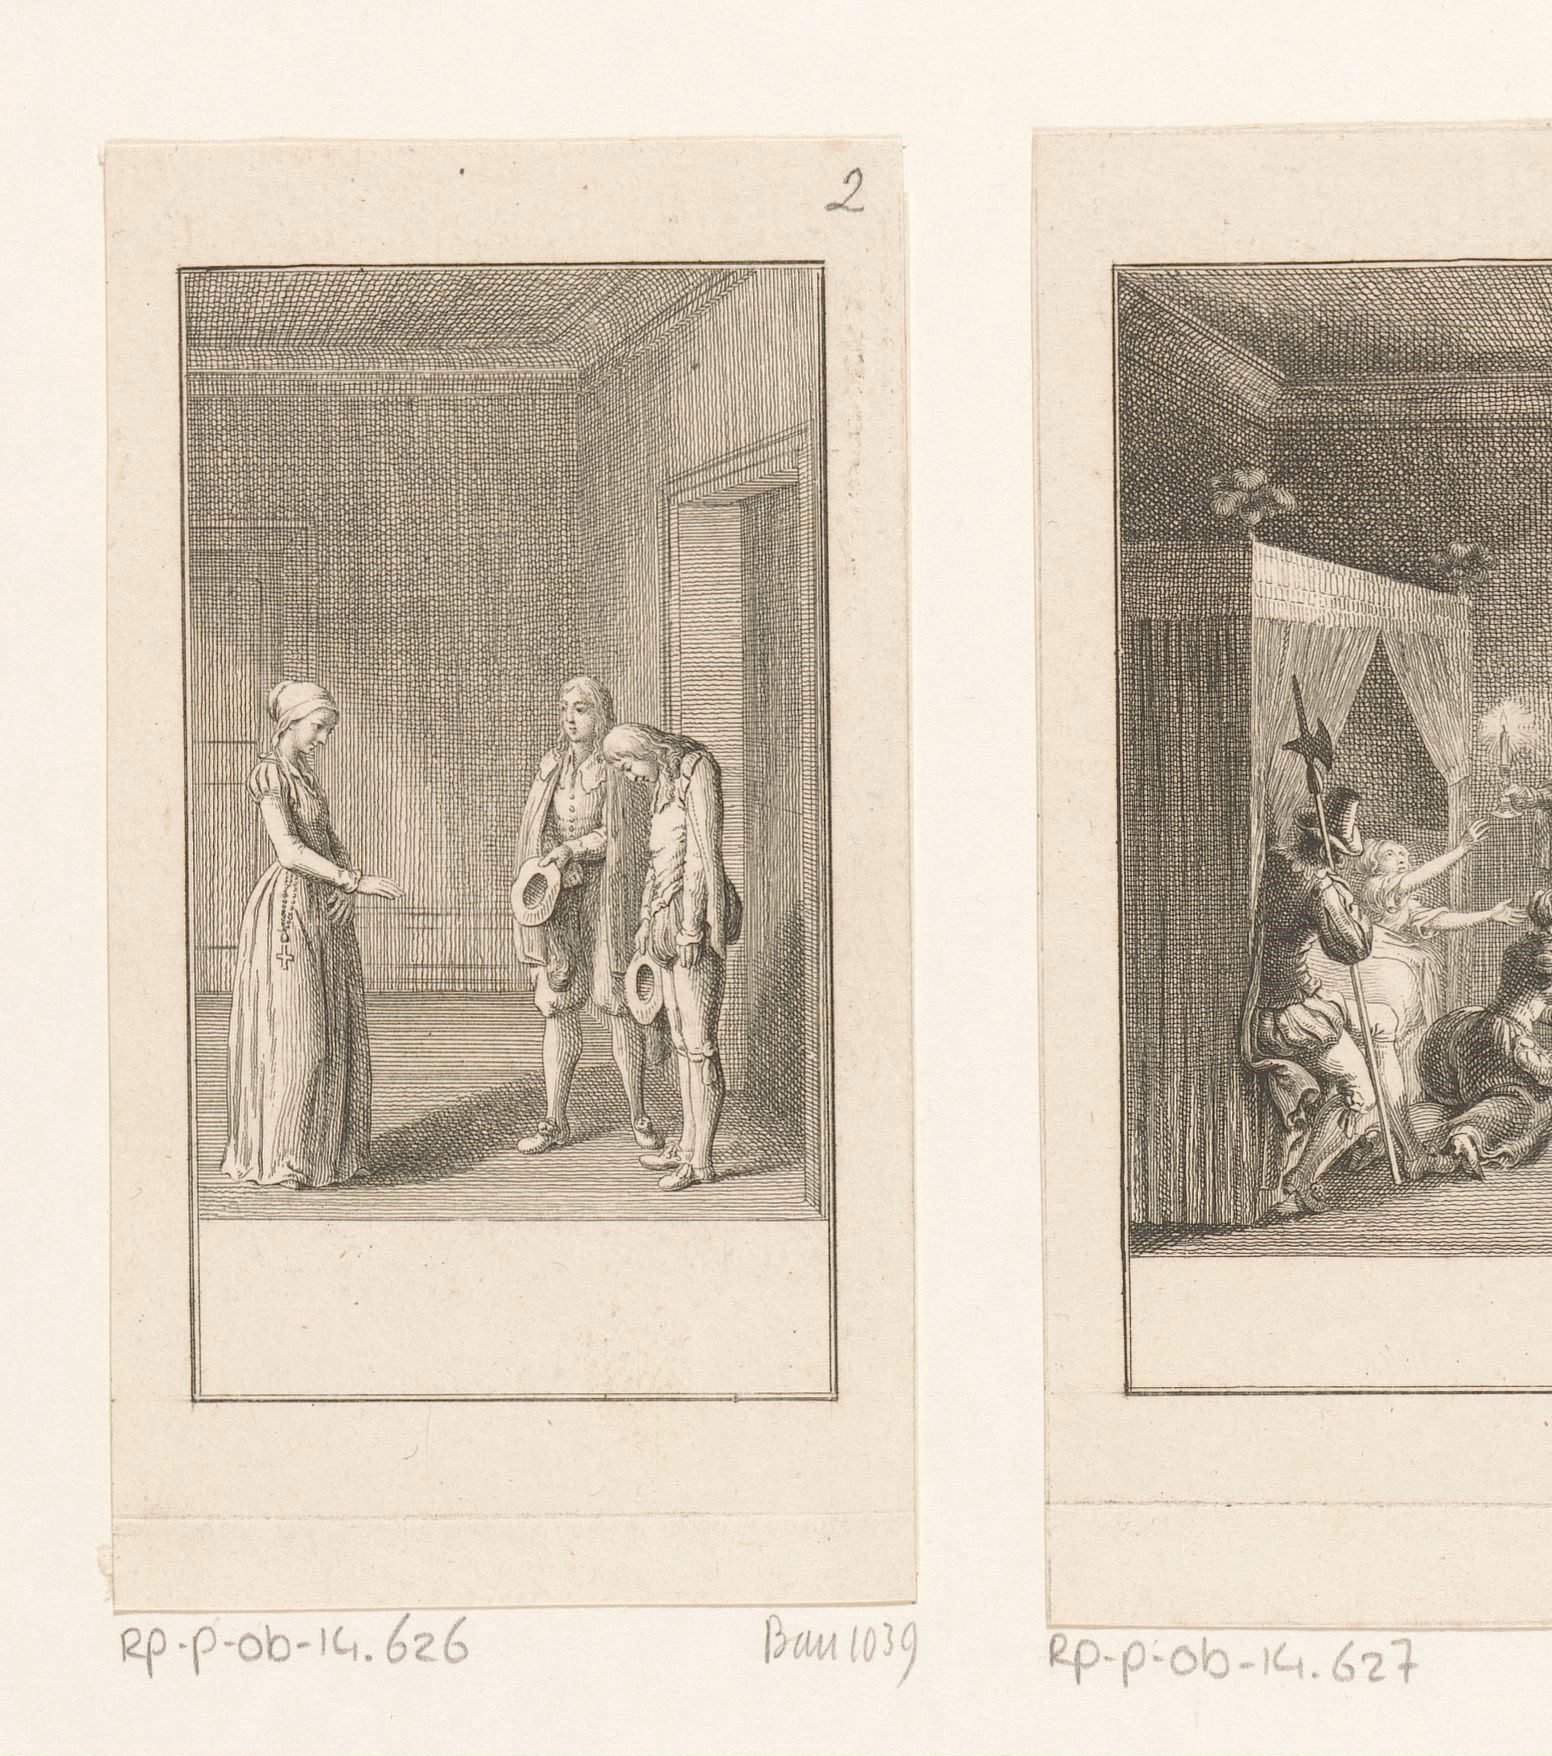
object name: print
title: Gil Blas en Fabricio ontvangen door Donna Hyacintha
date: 1783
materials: paper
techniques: etching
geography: gotha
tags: literature, aids for prayer, e.g. rosary, interior of the house, looking downwards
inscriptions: collector's mark: Lugt 2228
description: Vervaardigd voor 'Gil Blas de Santillane' van Alain-René Lesage. Een latere staat gebruikt in: Almanac de Gotha (...). Gotha: C. W. Ettinger, 1784.